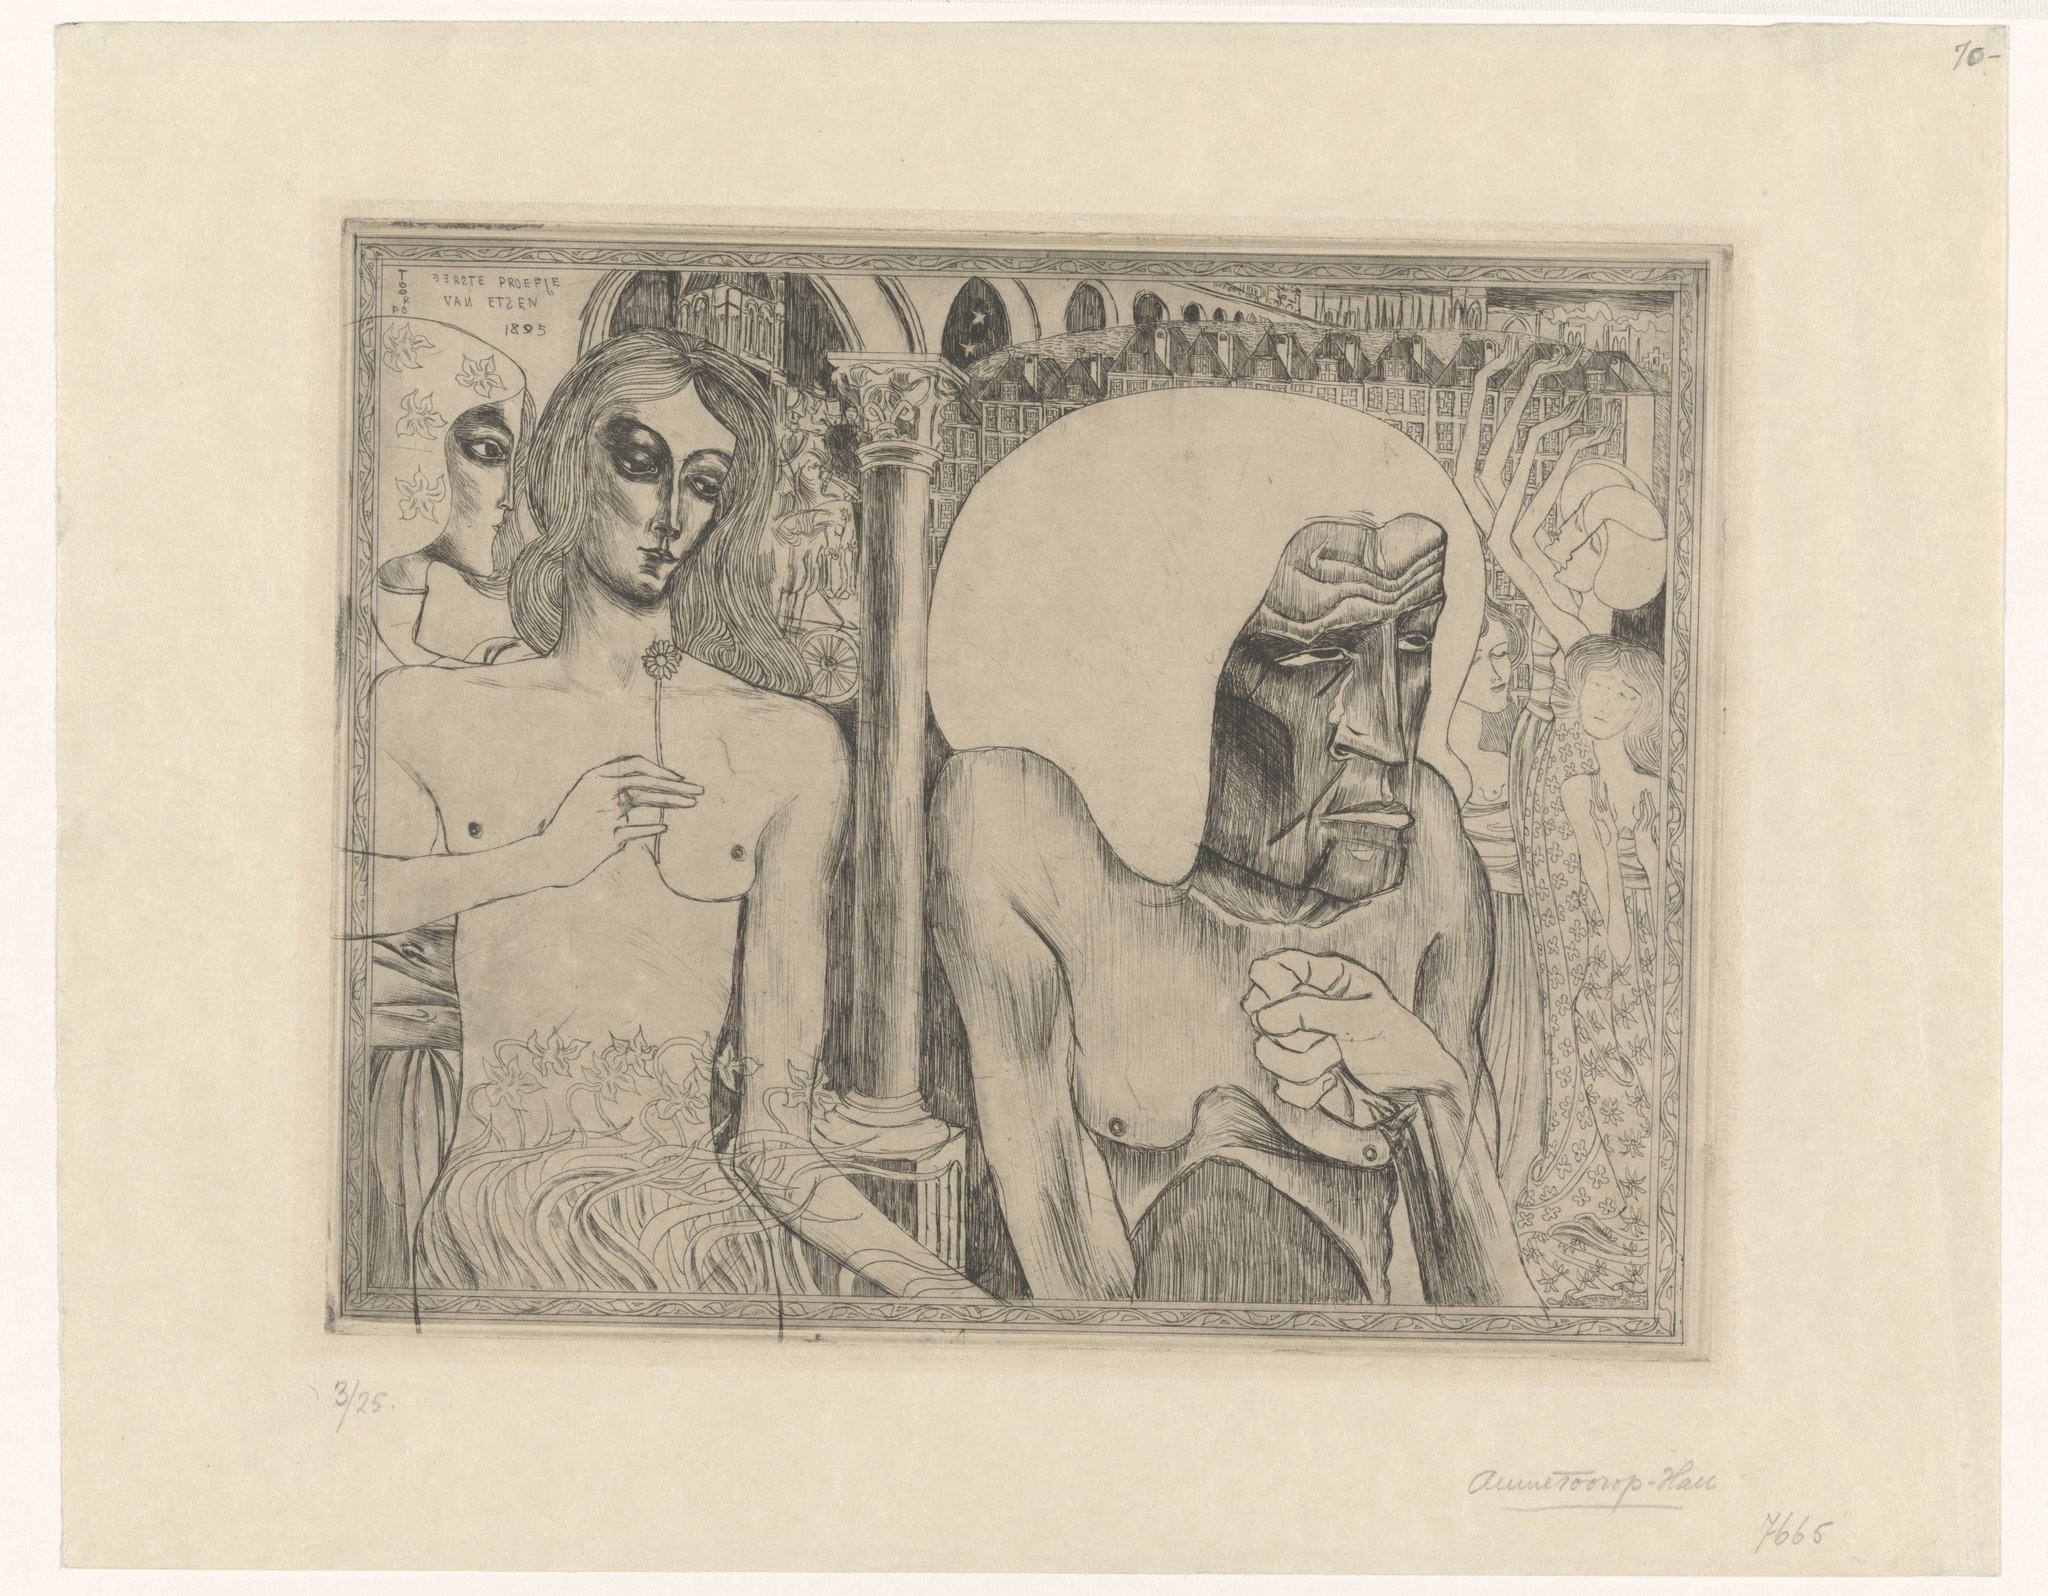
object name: print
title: Oude vrouw omringd door jonge vrouwen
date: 1895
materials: paper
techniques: drypoint, intaglio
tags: adolescent, young woman, maiden, old woman, human life divided into stages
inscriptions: collector's mark: Lugt 2760, collector's mark: Lugt 2228, collector's mark: Lugt 2401a, annotation: ‘Eerste proefje/ van etsen’, signature: ‘Annie Toorop-Hall’